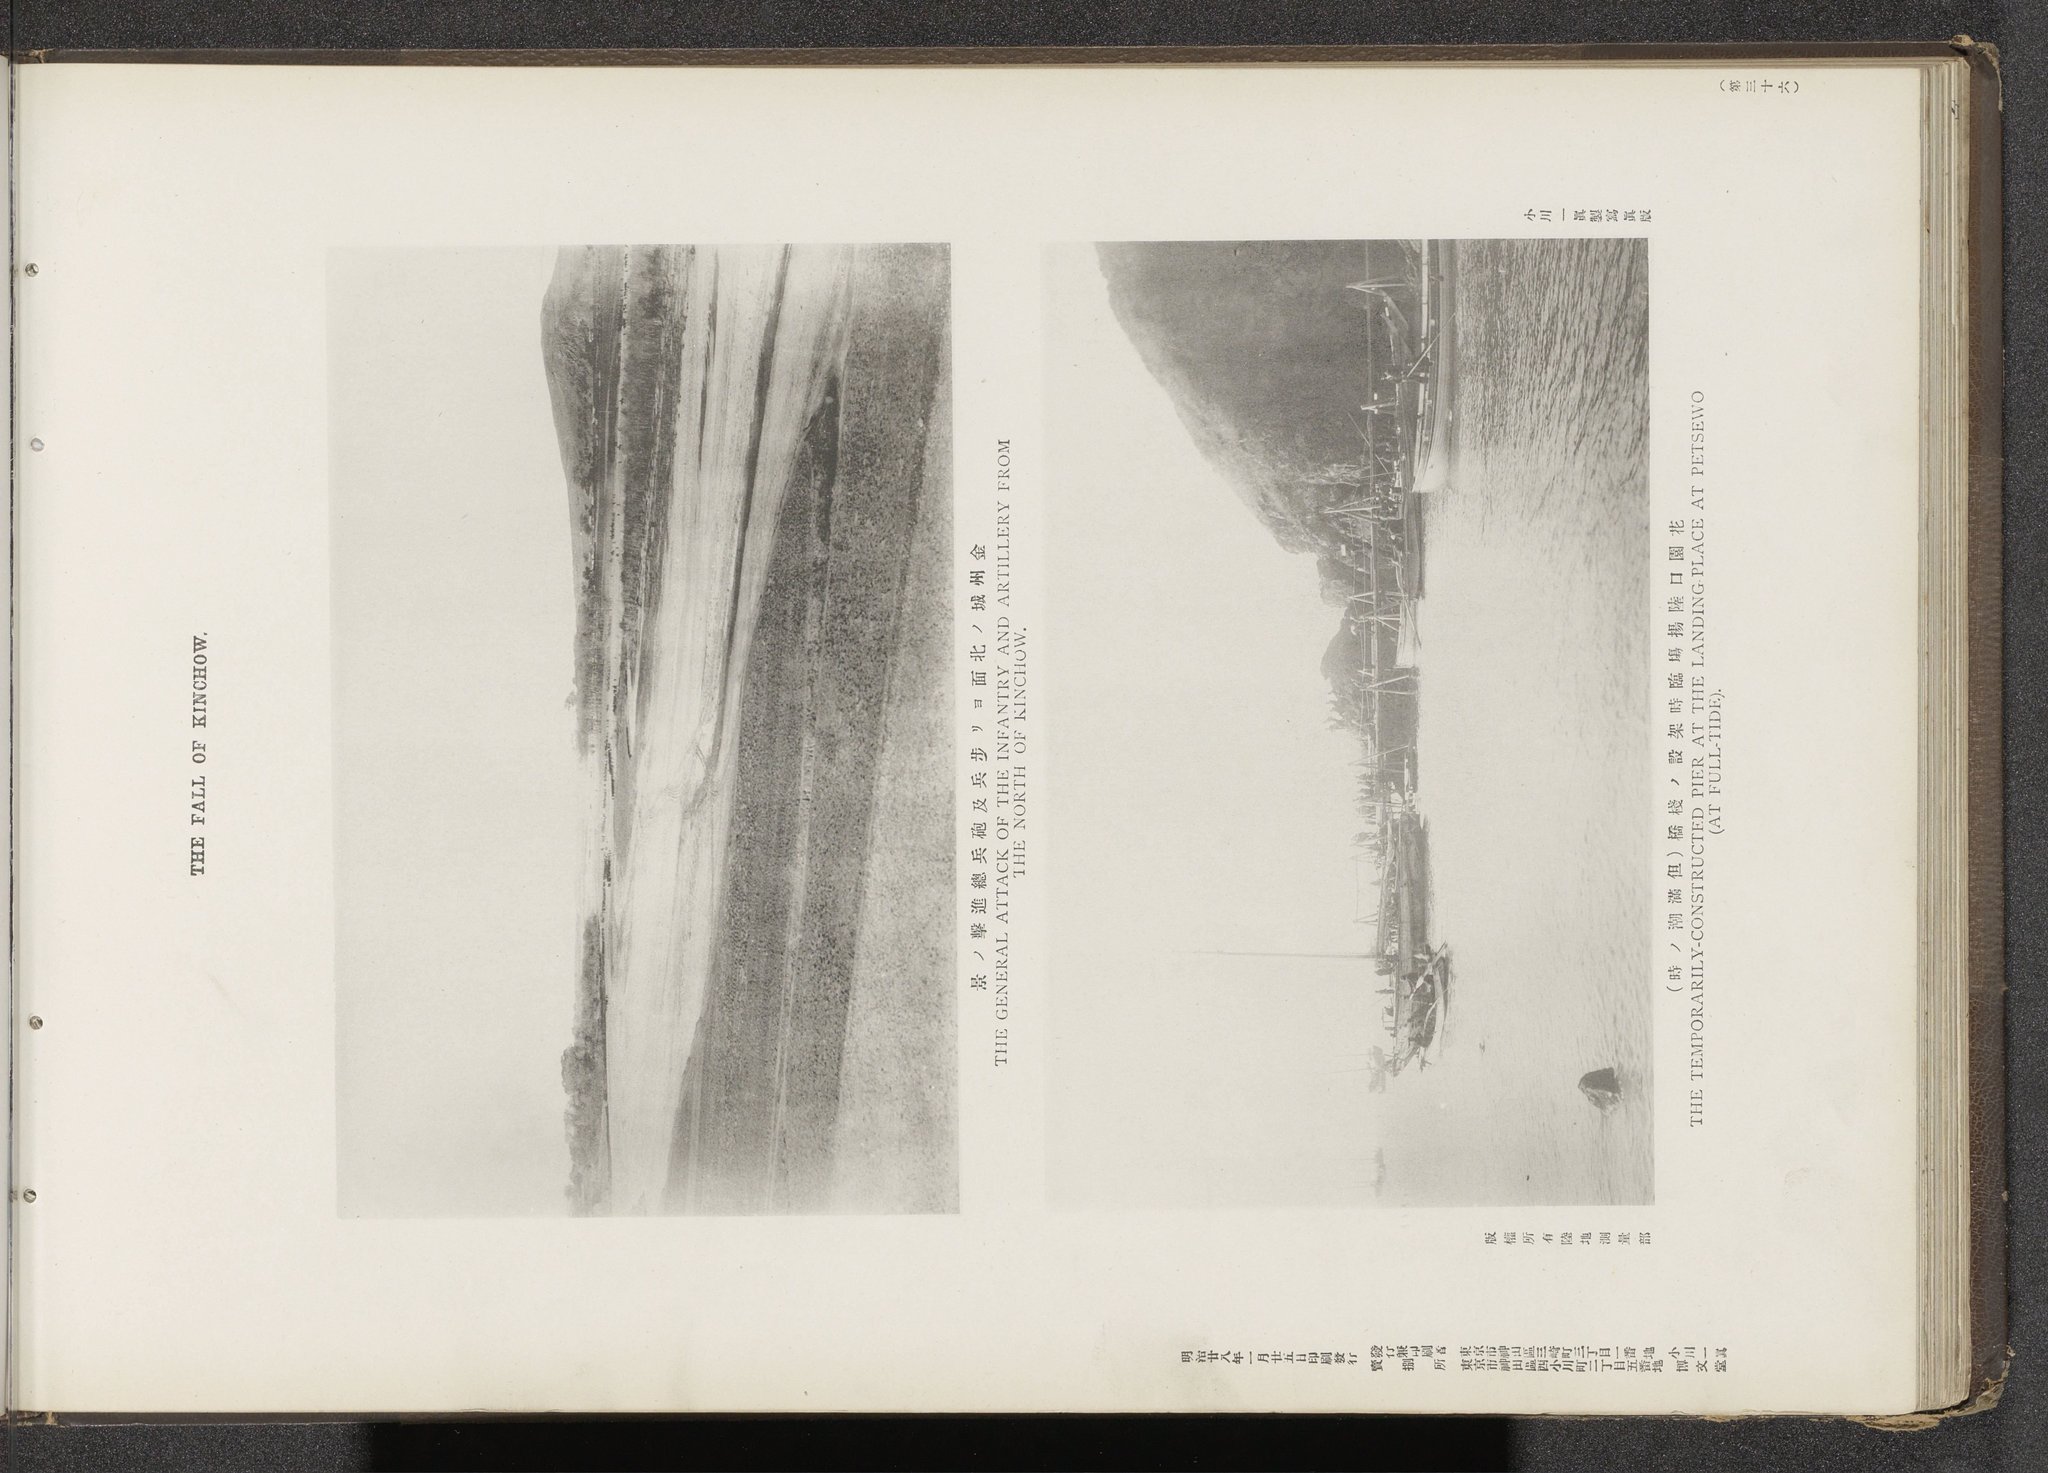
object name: page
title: The general attack of the infantry and artillery form the North of Kinchow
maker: kazumasa ogawa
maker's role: auteur, fotograaf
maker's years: 1860-1929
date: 1894-1895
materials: paper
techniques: photograph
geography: china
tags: ships (in general), assault ~ siege, pier, quay, wharf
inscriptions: inscription: ‘The fall of Kinchow.’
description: Boven een gezicht op de infanterieaanval op Chinchow, onder boten langs een tijdelijke pier bij Petsewo.